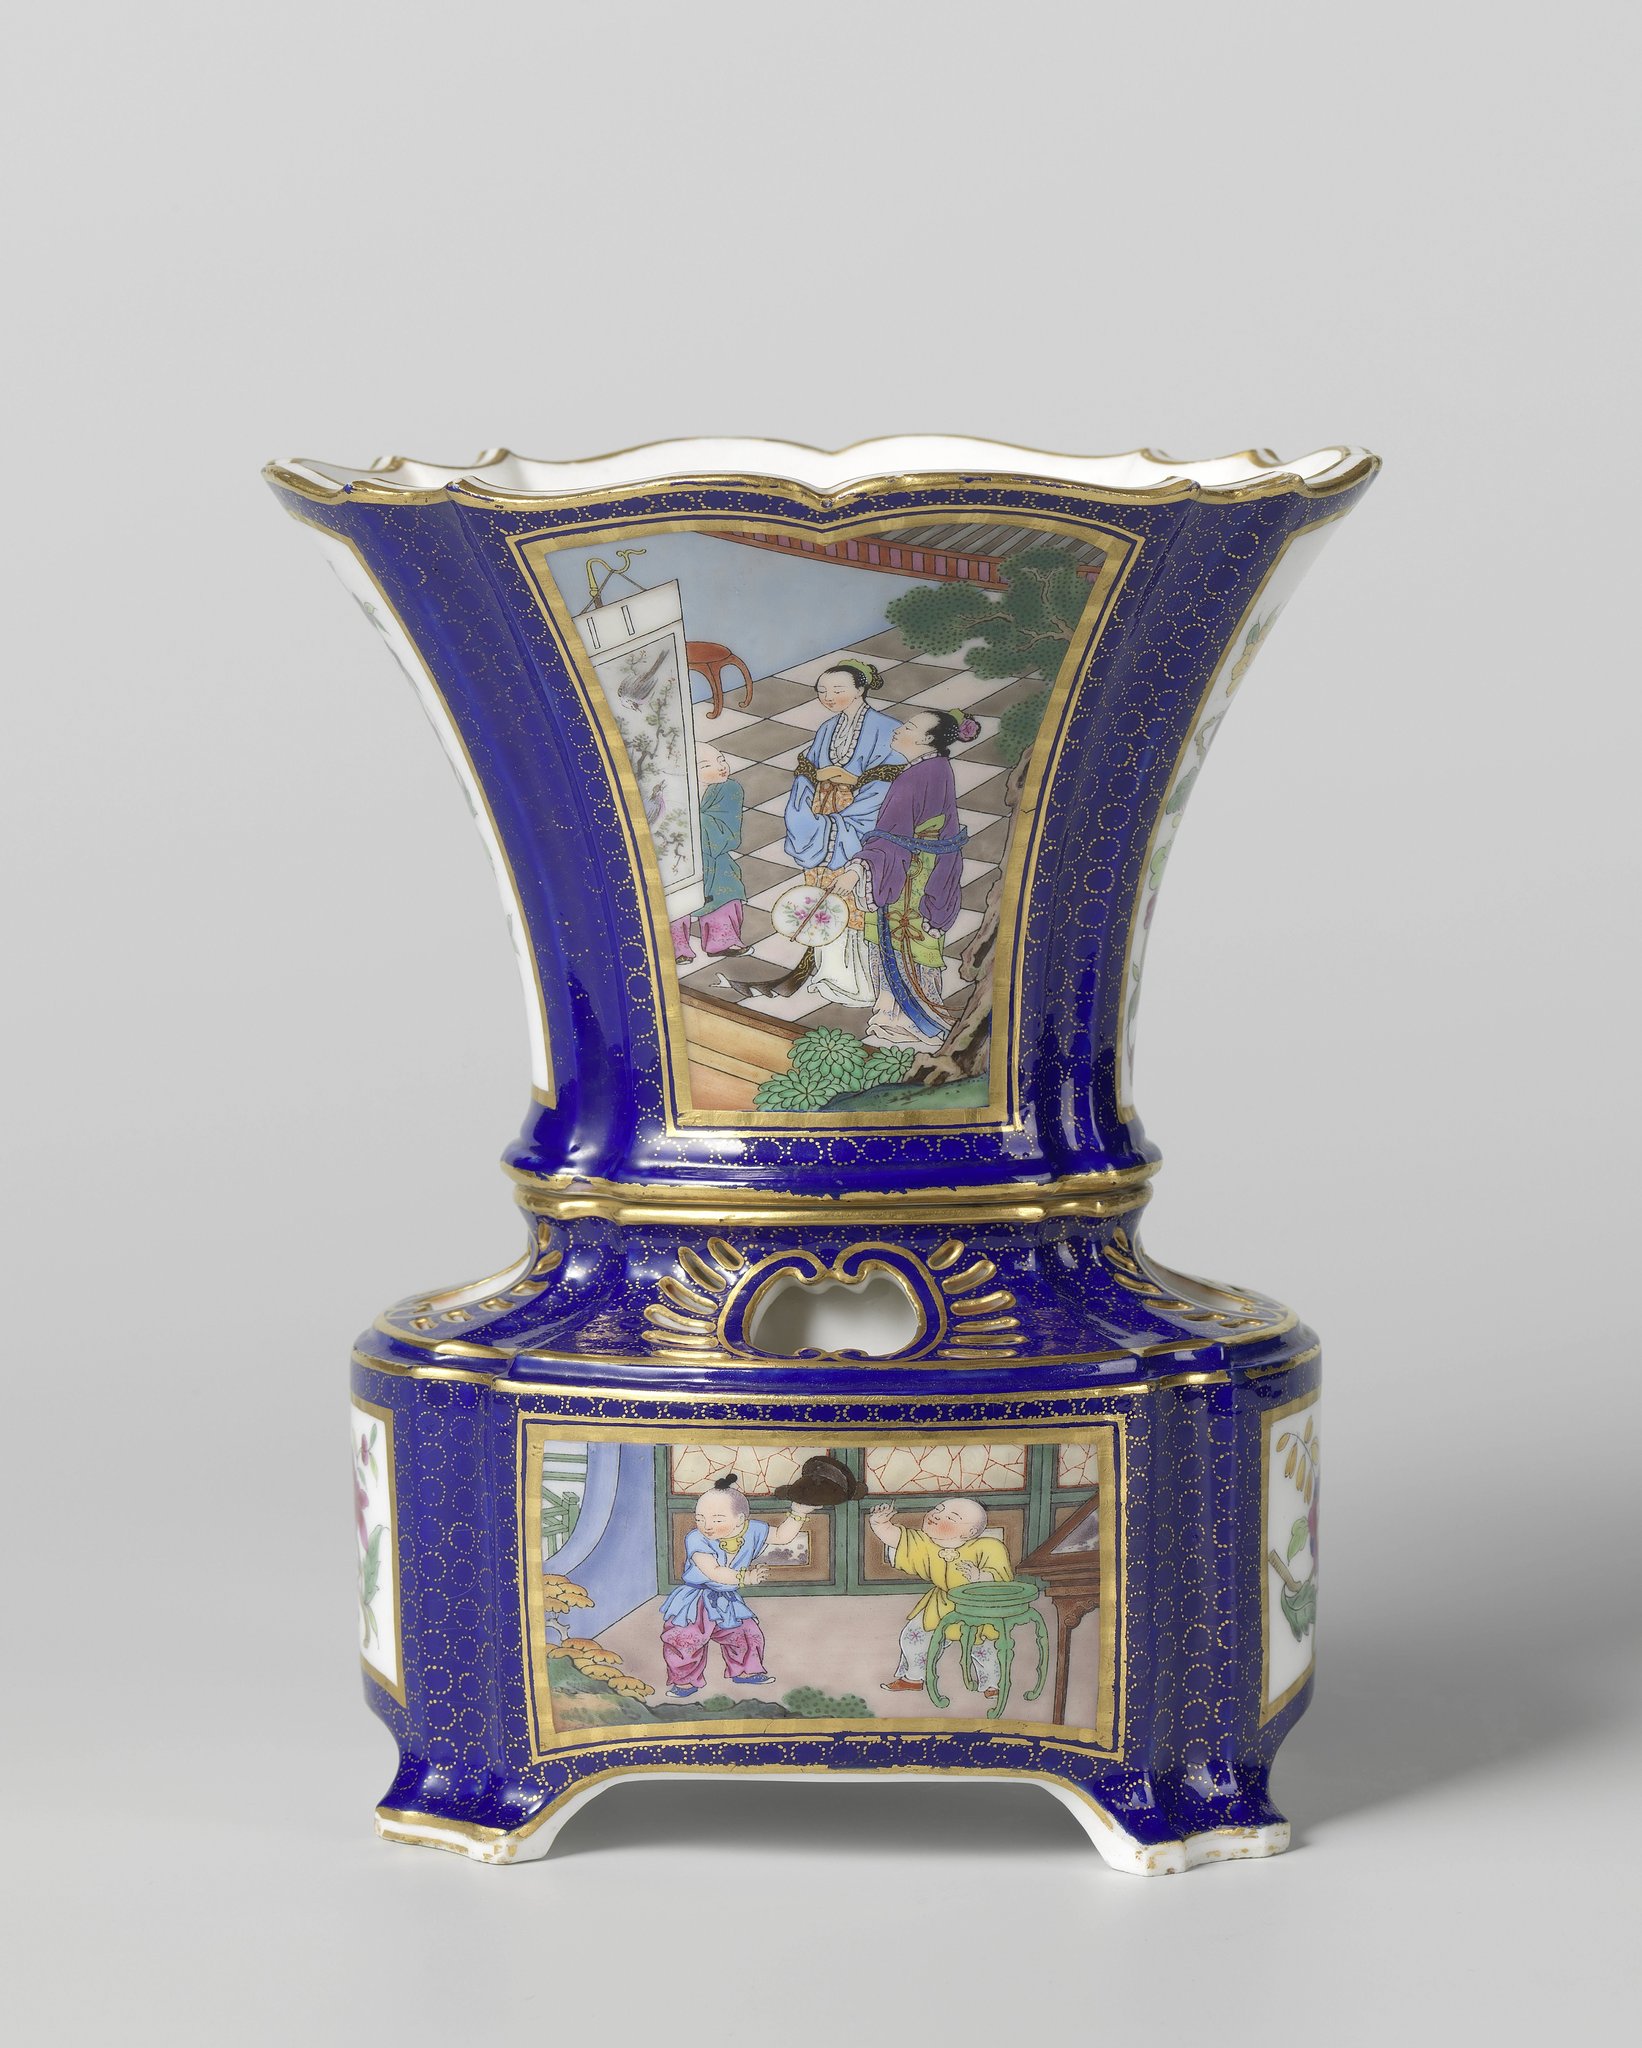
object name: vase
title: Pair of vases (vase hollandais nouvelle forme)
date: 1763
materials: porcelain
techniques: gilding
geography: sèvres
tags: chinese (+ other cultural aspects)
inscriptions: mark: ‘5’, factory mark, painter's mark: ‘k’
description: These vases were used as planters for bulbs or other plants, which were nourished with water that filled the stands. The delicately painted motifs of Chinese figures and flowers derive directly from 18th-century Chinese art: porcelain, enamels or paintings on paper. The highly talented Dodin was the only painter of this kind of decoration on Sèvres porcelain.